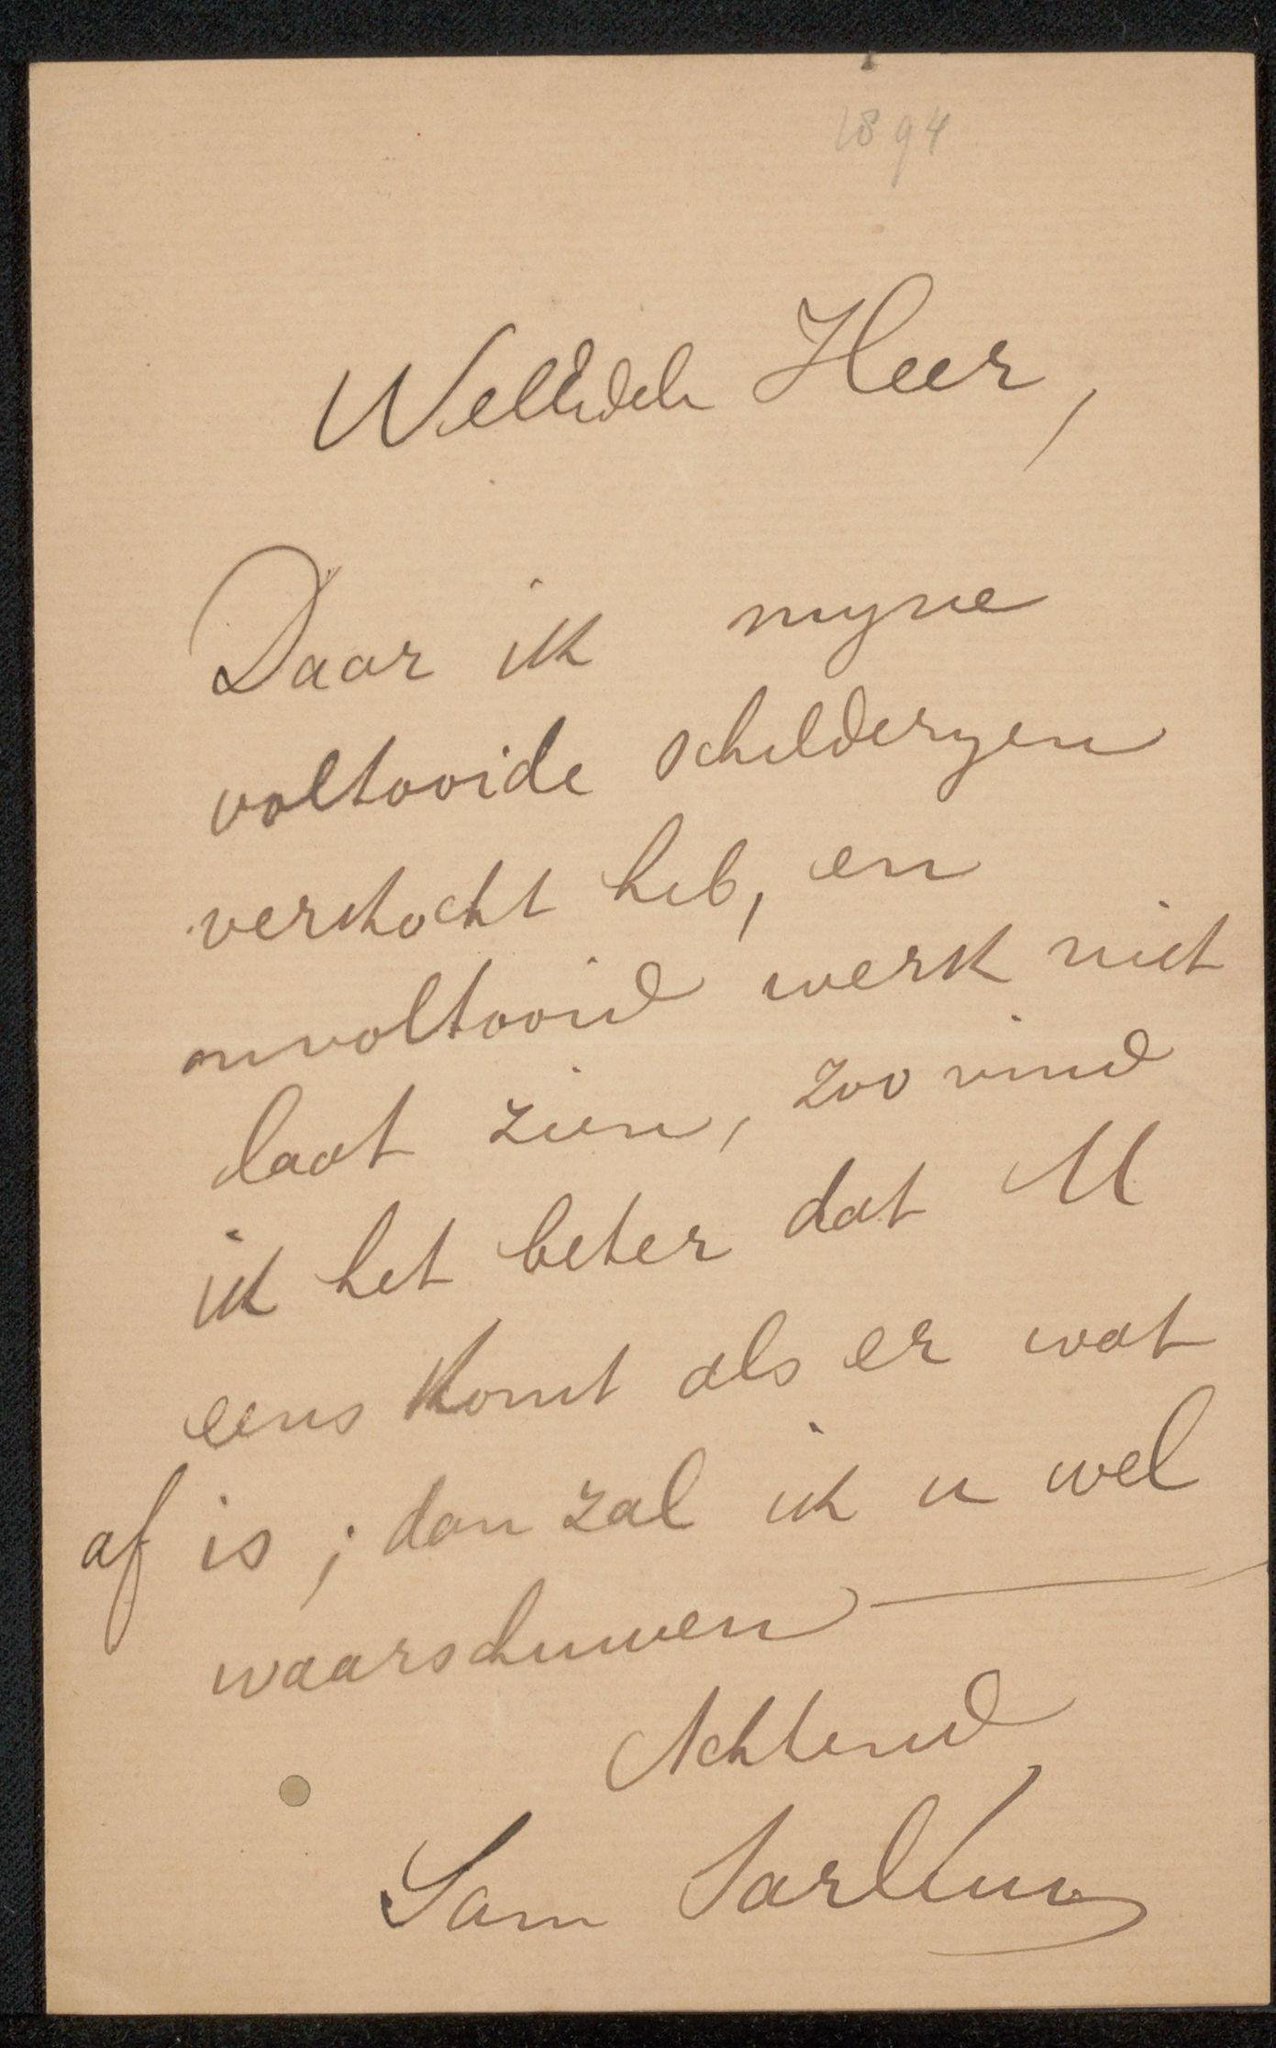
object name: letter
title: Brief aan Philip Zilcken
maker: léonard sarluis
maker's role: draughtsman, painter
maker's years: 1874-1949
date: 1884-1930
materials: ink, paper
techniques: pen, writing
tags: philip zilcken, painting (including book-illumination, miniature-painting)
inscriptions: collector's mark: ‘RPK’